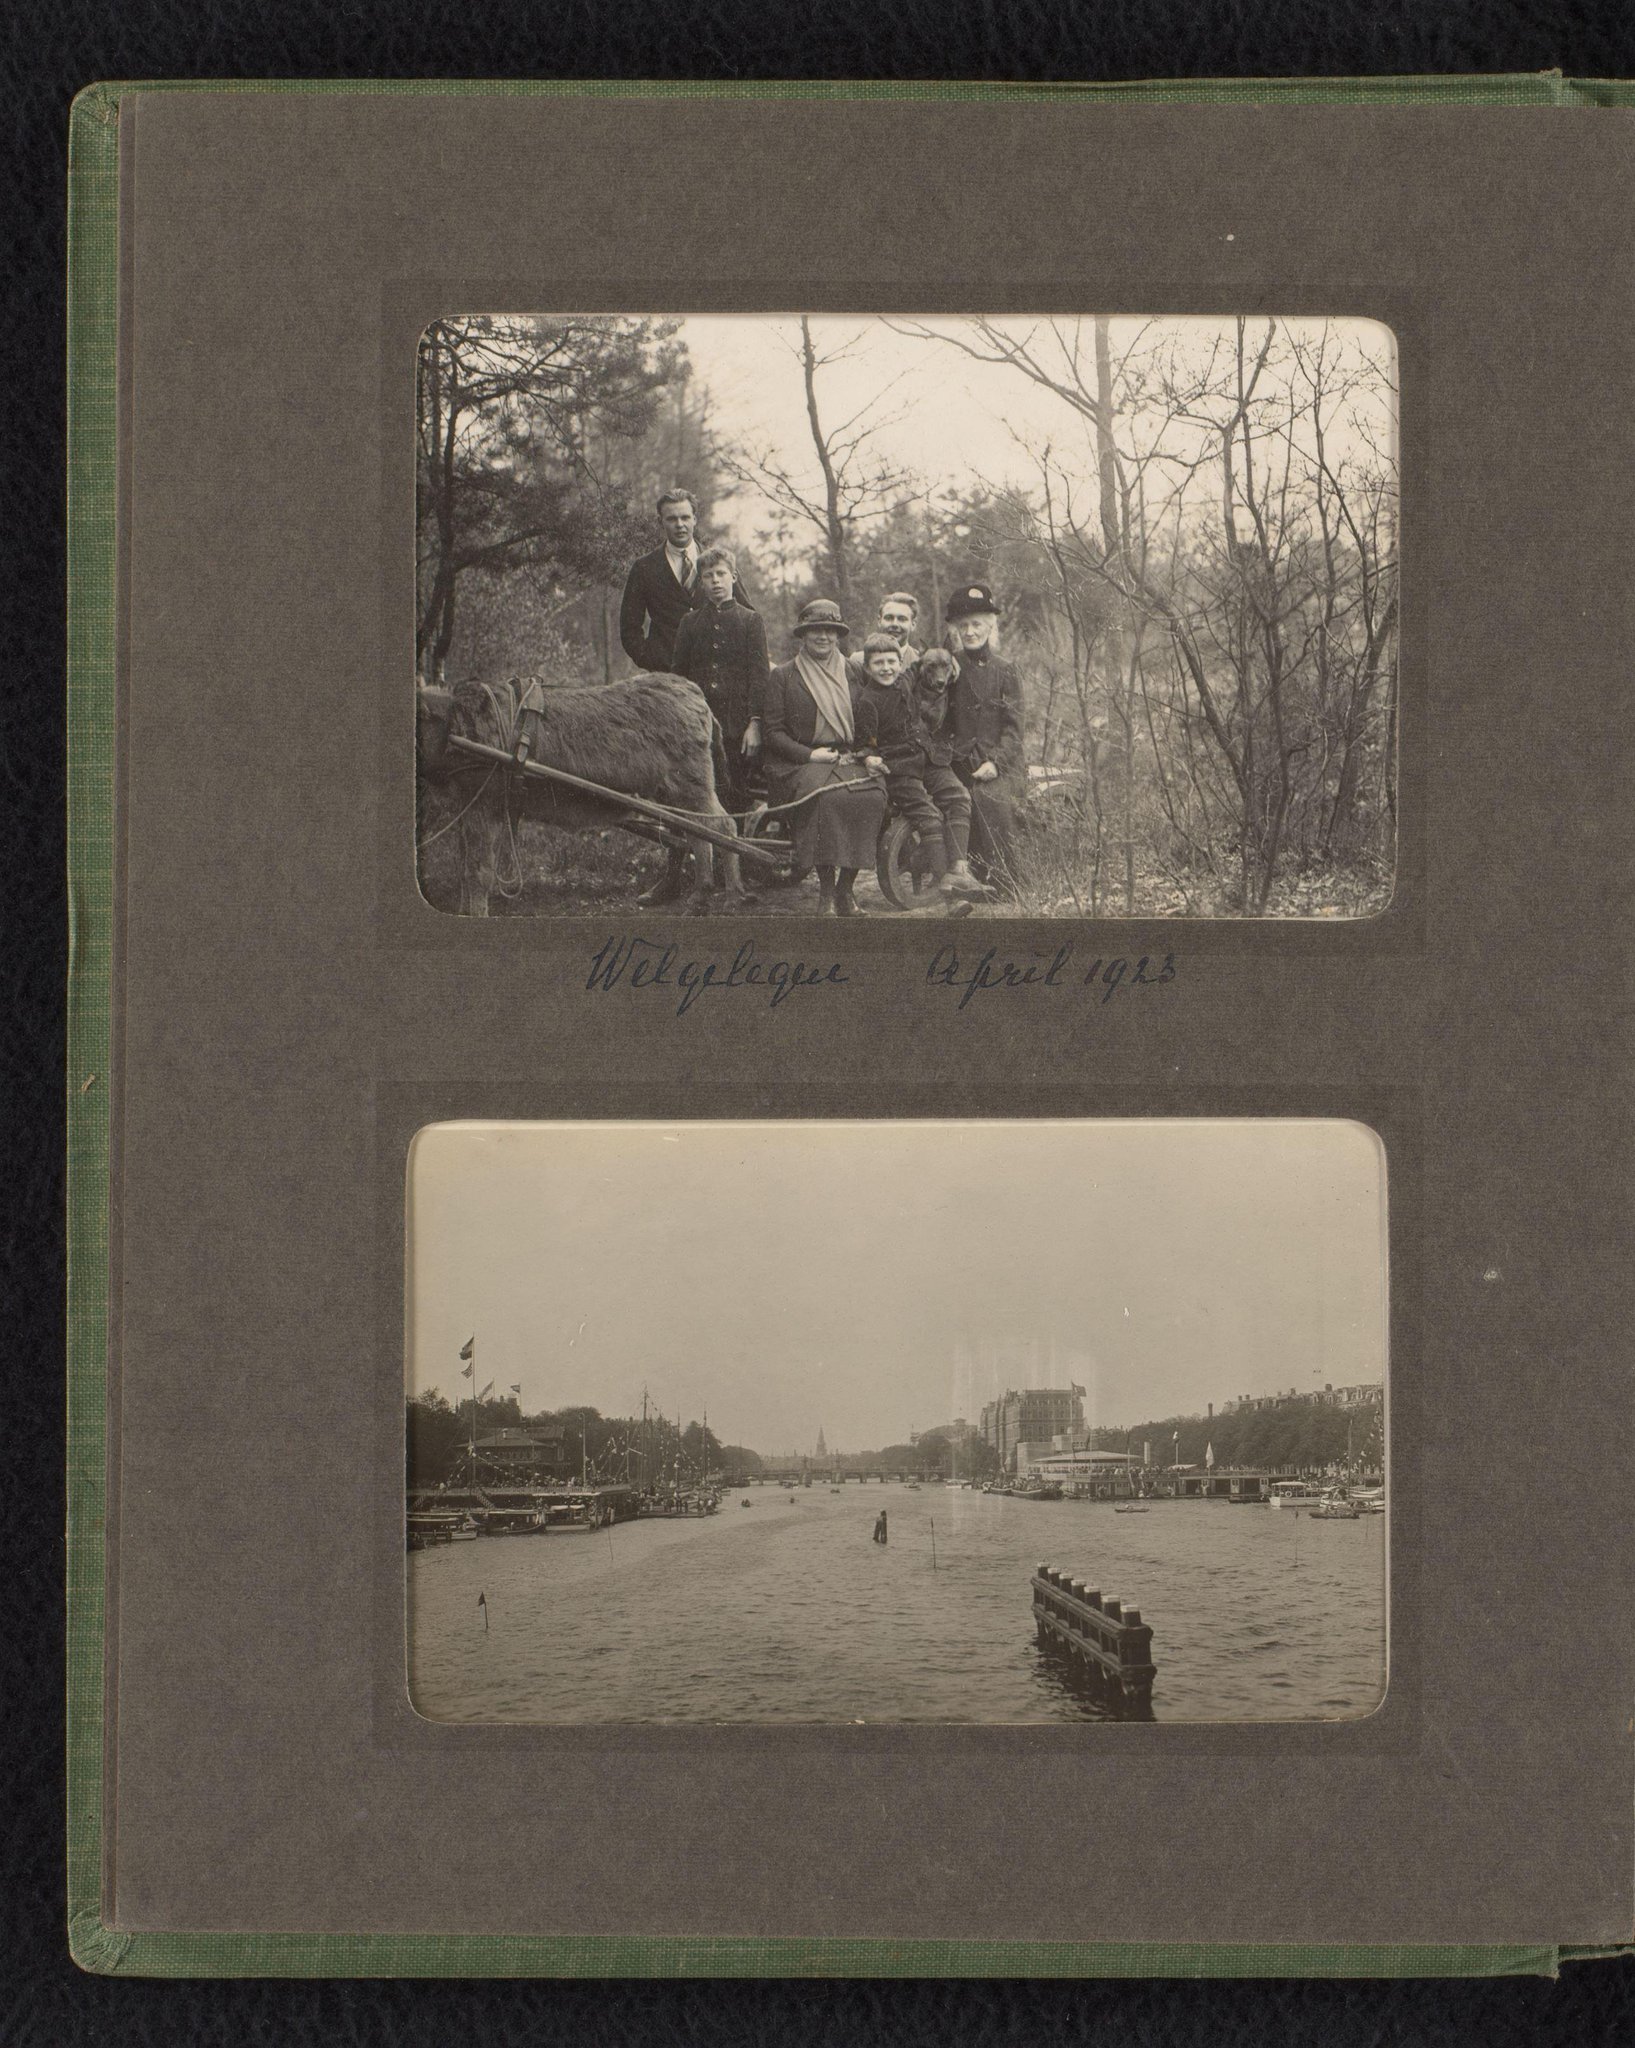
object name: photograph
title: Twee foto's van de familie Van den Berg en een gezicht op de Amstel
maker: hendrik herman van den berg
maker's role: amateurfotograaf, jurist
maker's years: 1875-1944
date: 1904-1923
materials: paper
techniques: gelatin silver print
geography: netherlands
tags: river, family group, especially parents with their child(ren)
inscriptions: inscription: ‘Welgelegen April 1923’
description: Deze foto's maken deel uit van een album.